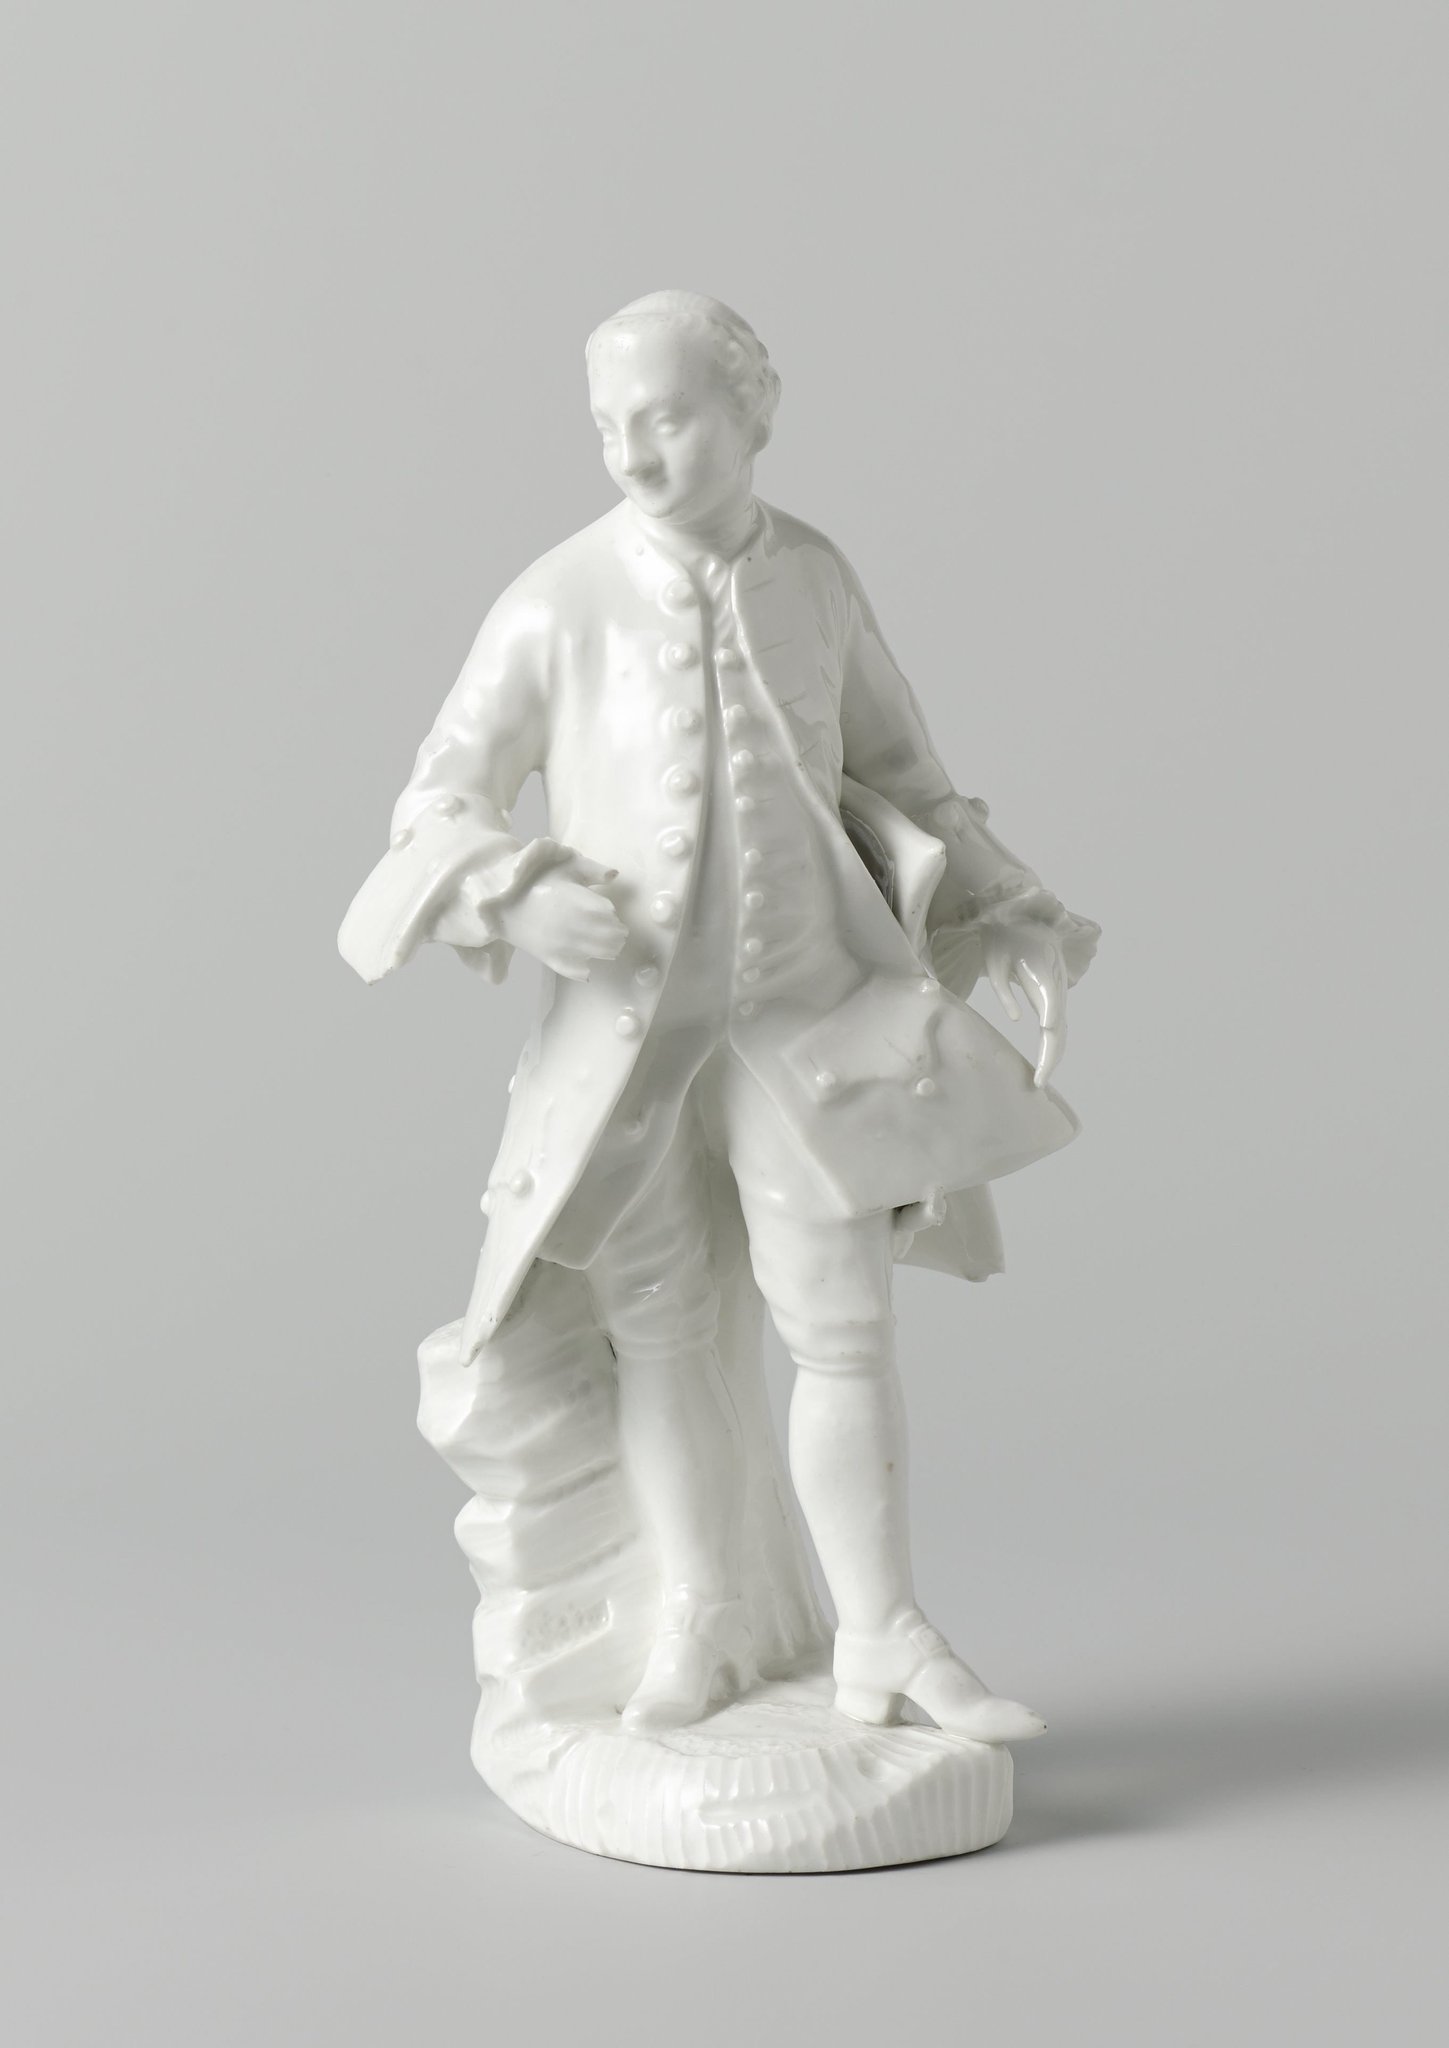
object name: figure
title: Figure of a man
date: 1752-1757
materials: glaze, porcelain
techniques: firing, forming, vitrification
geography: berlin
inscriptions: mark: ‘W/ 2/90/49’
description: Two figures. Porcelain. Berlin, c. 1752 - 1757, factory of Wilhelm Kaspar Wegely, model by Ernst Heinrich Reichard.